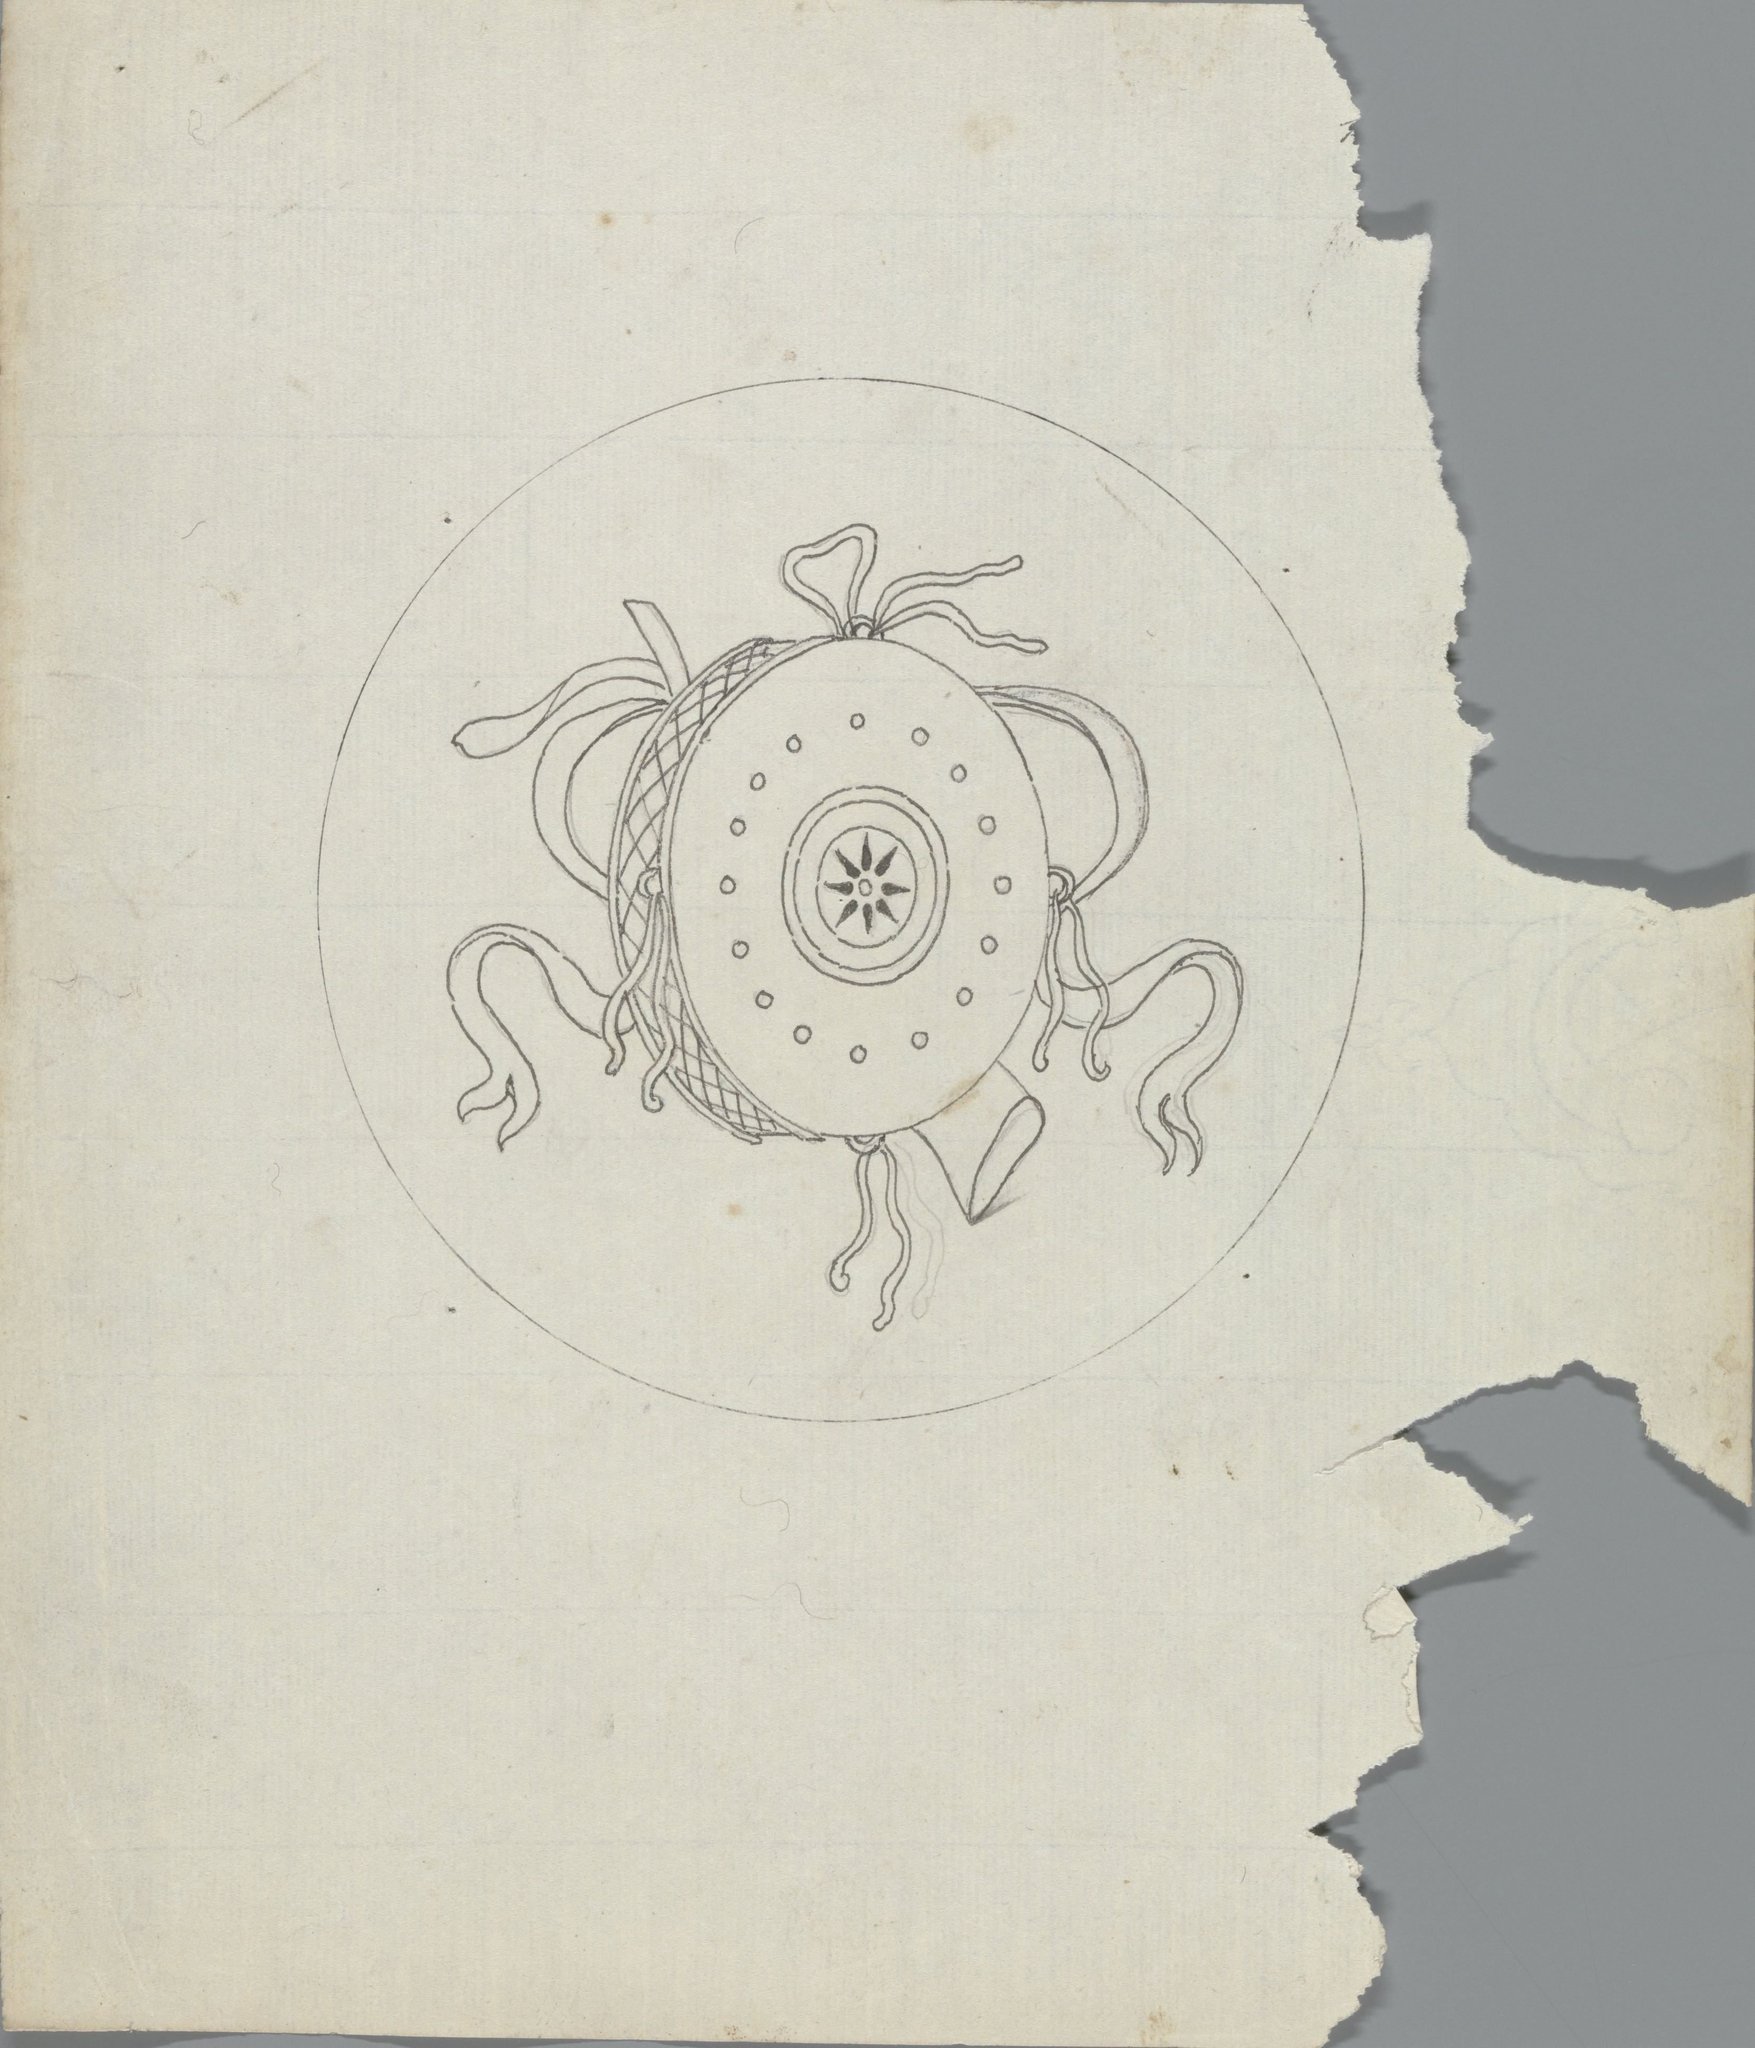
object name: design drawing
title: Trommel en ander instrument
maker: pierre félix van doren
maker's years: 1797-1856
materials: graphite, ink, paper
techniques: pen in black ink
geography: brussels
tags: trophy, i.e.: decorative arrangement of symbolic or typical objects ~ ornament, percussion instruments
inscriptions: watermark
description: Een van 103 ontwerpen voor marqueterie van aan linten opgehangen muziekinstrumenten in ronde medaillons, bestemd voor de set stoelen gemaakt door Van Doren voor de grote zaal van het Paleis van de Prins van Oranje in Brussel in 1828.